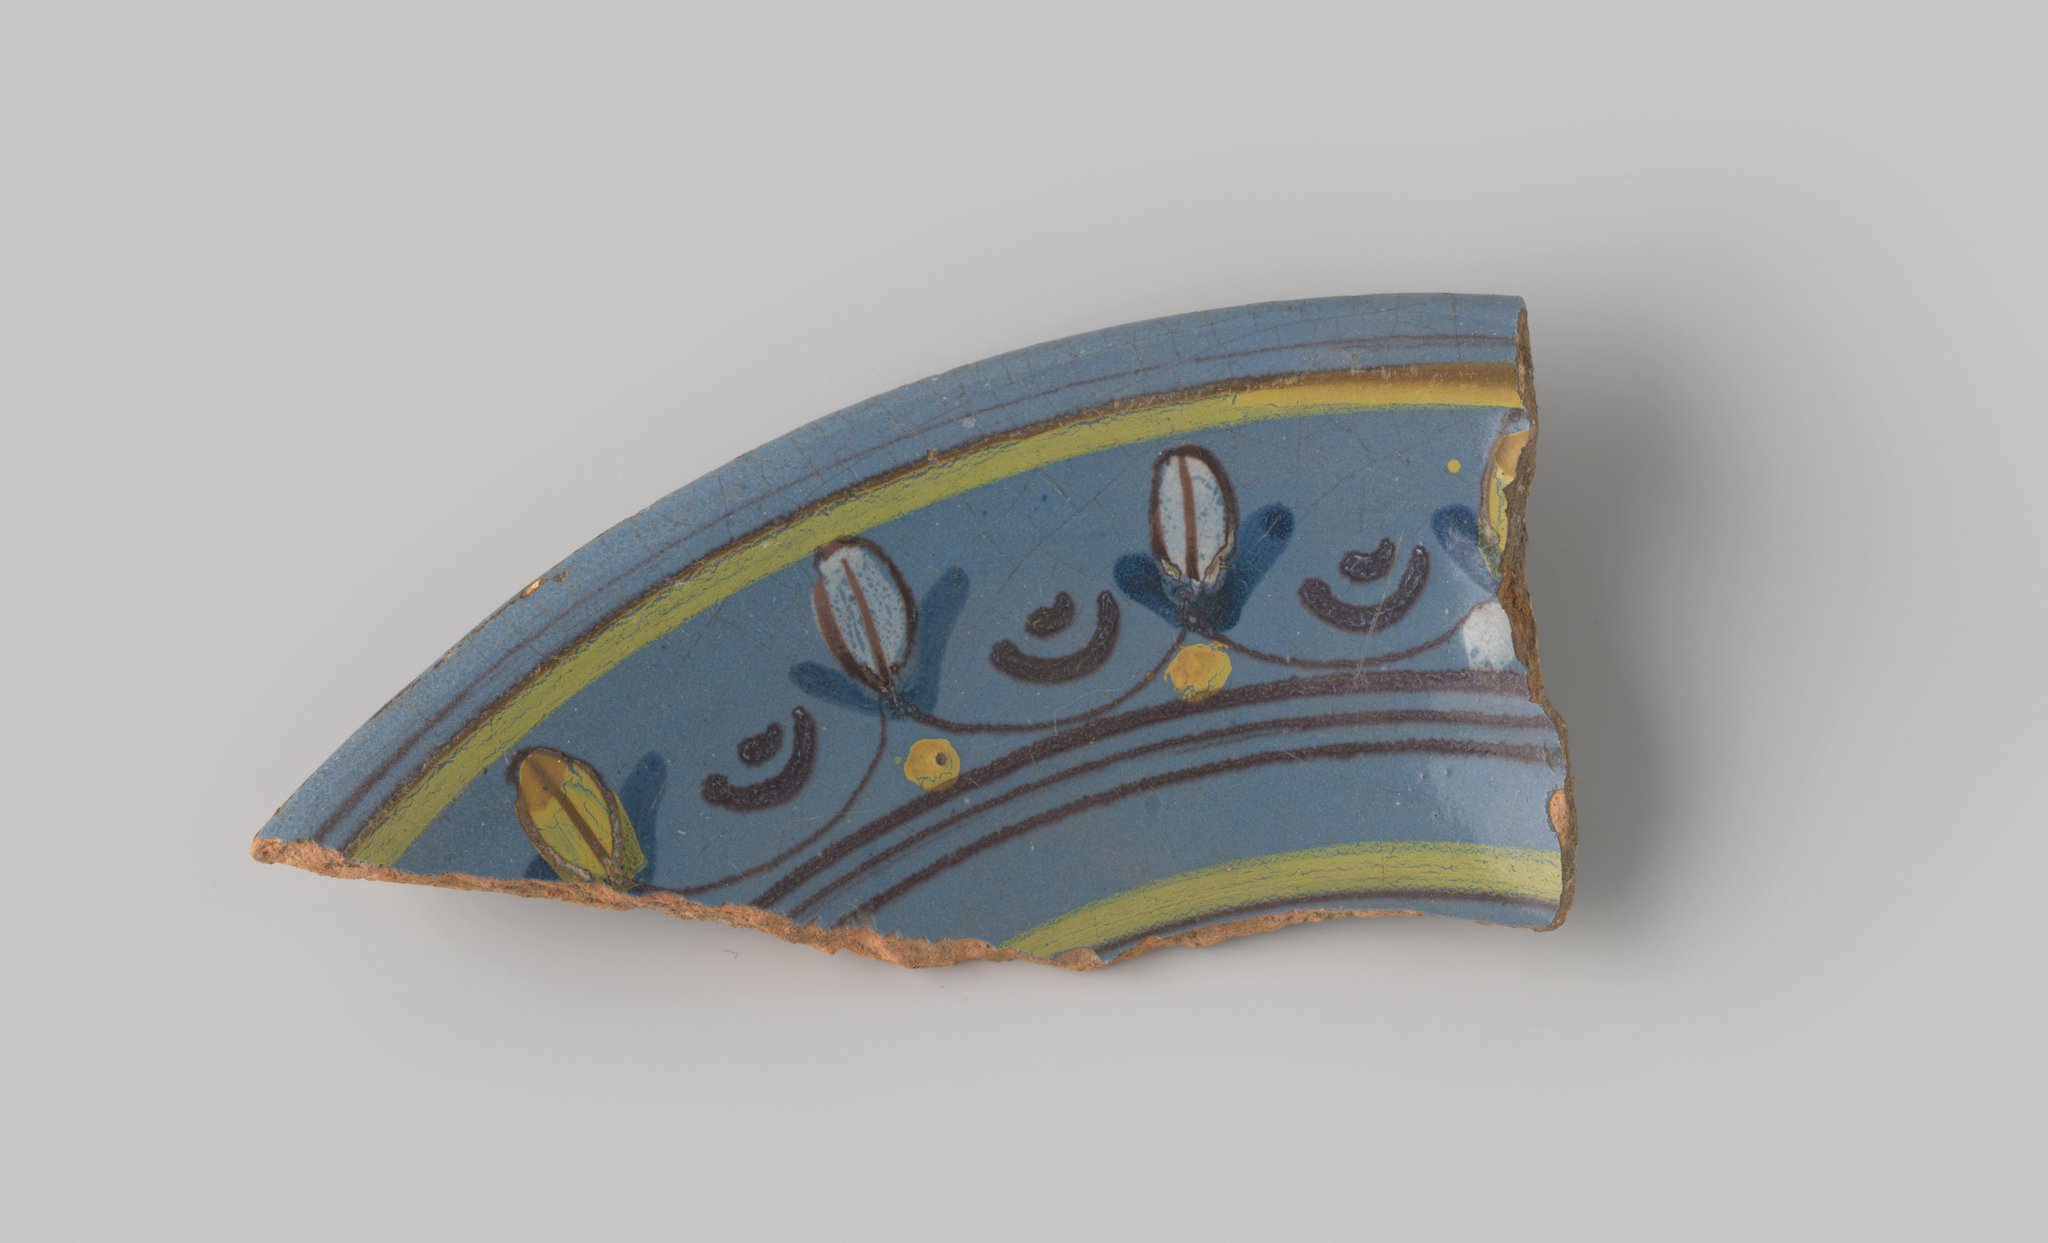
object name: sherd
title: Scherf van roodbakkend aardewerk, aan de bovenzijde voorzien van blauw glazuur met decoratie van strepen bloemen in bruin, geel, groen en wit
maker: Anonymous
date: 1600-1650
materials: earthenware, glaze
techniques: maiolica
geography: northern netherlands